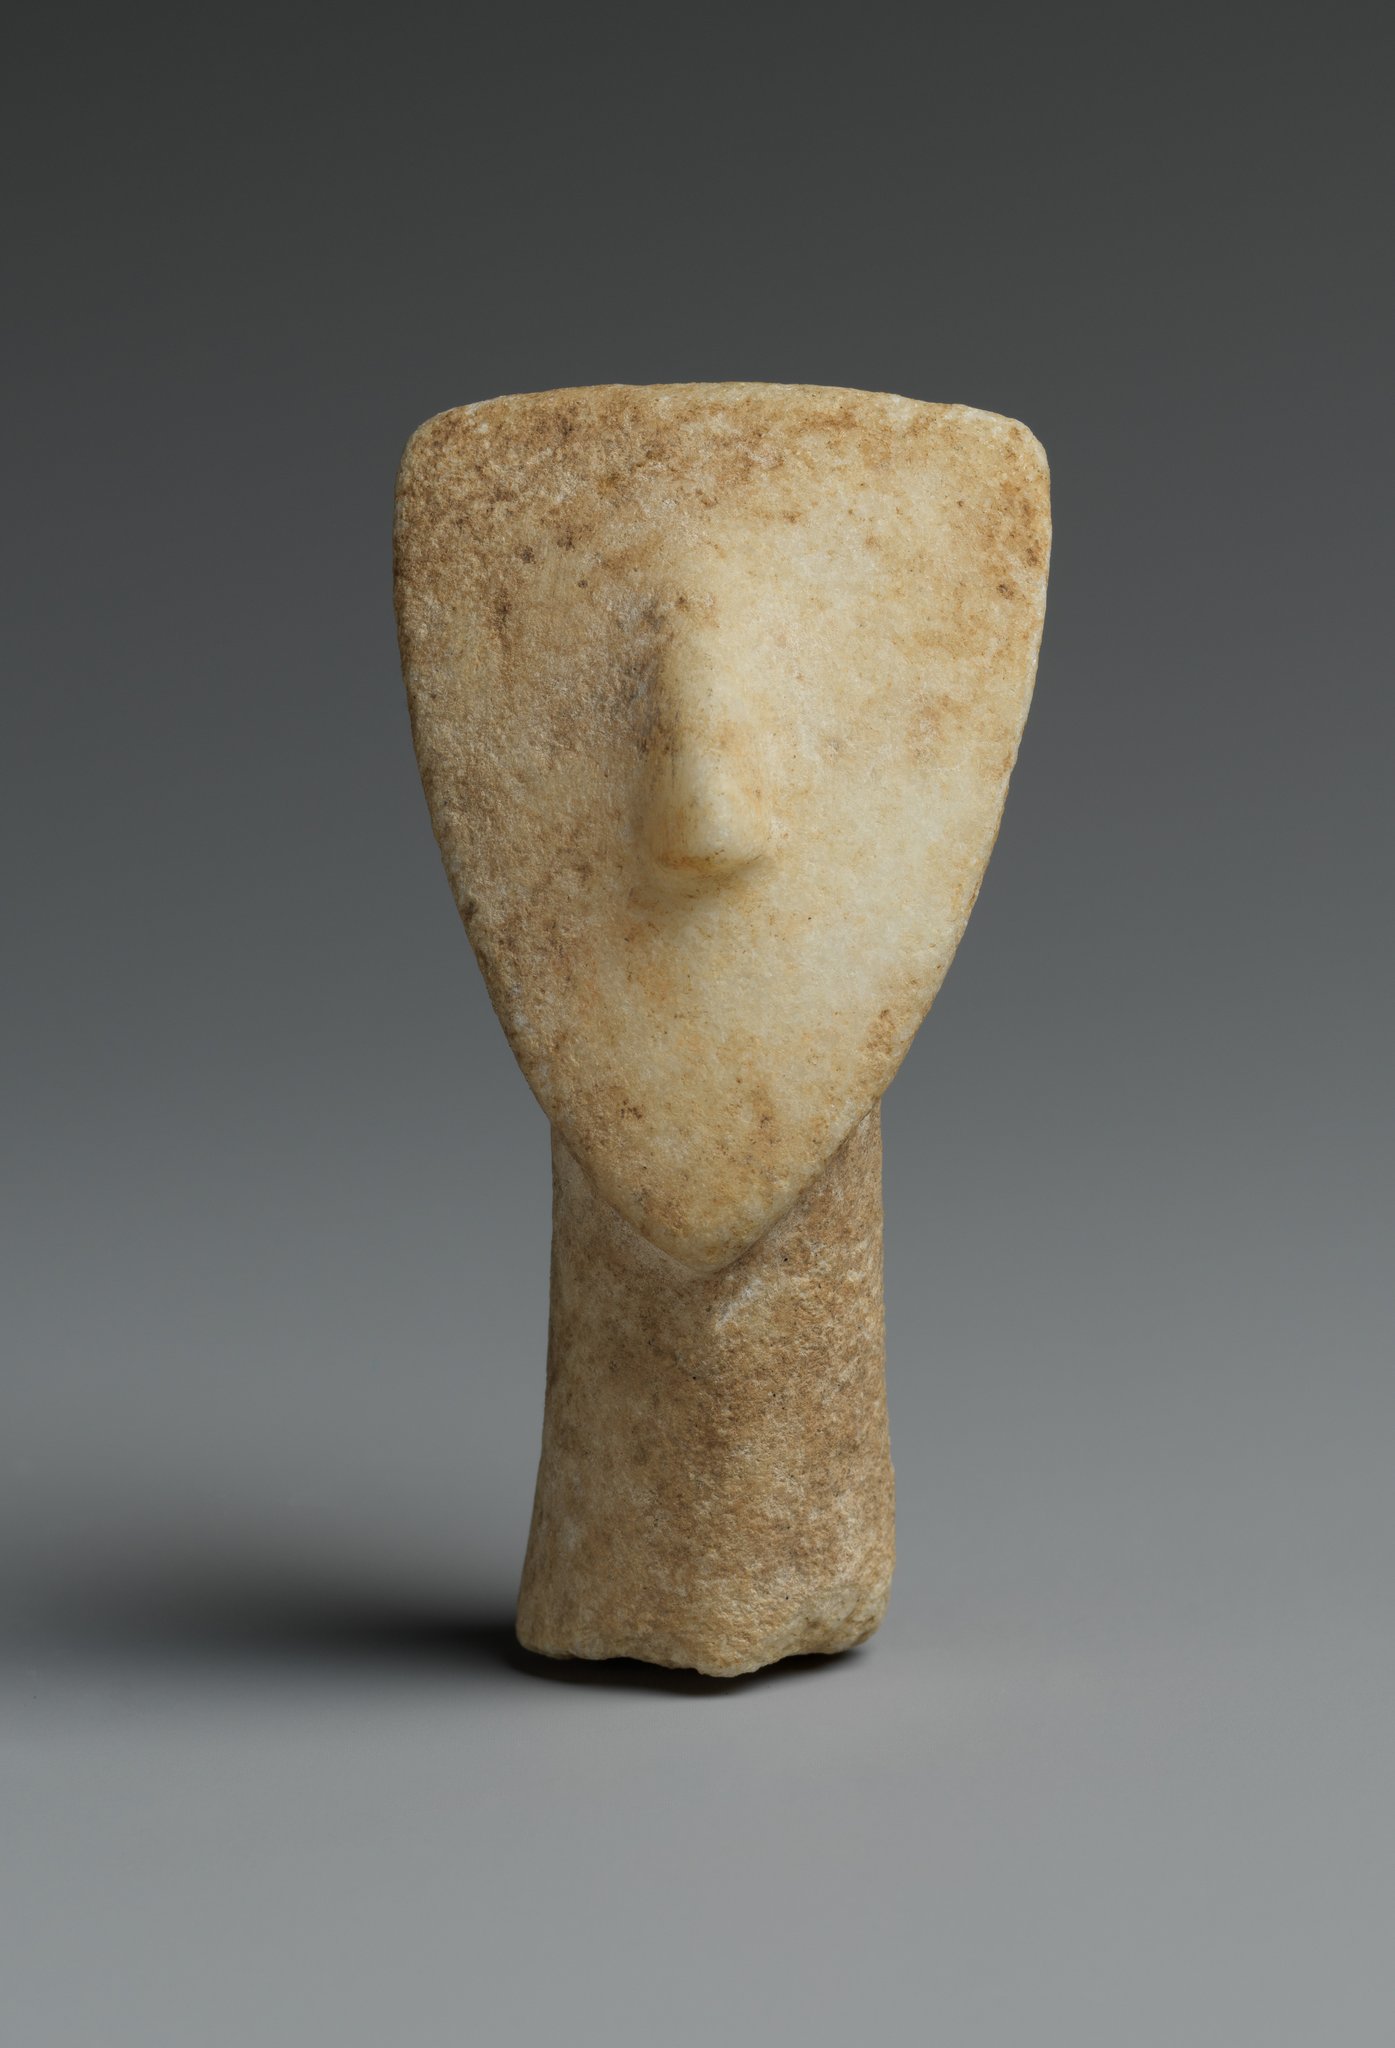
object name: head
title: Head and neck from a marble figure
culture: cycladic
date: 2700-2300 BCE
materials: marble